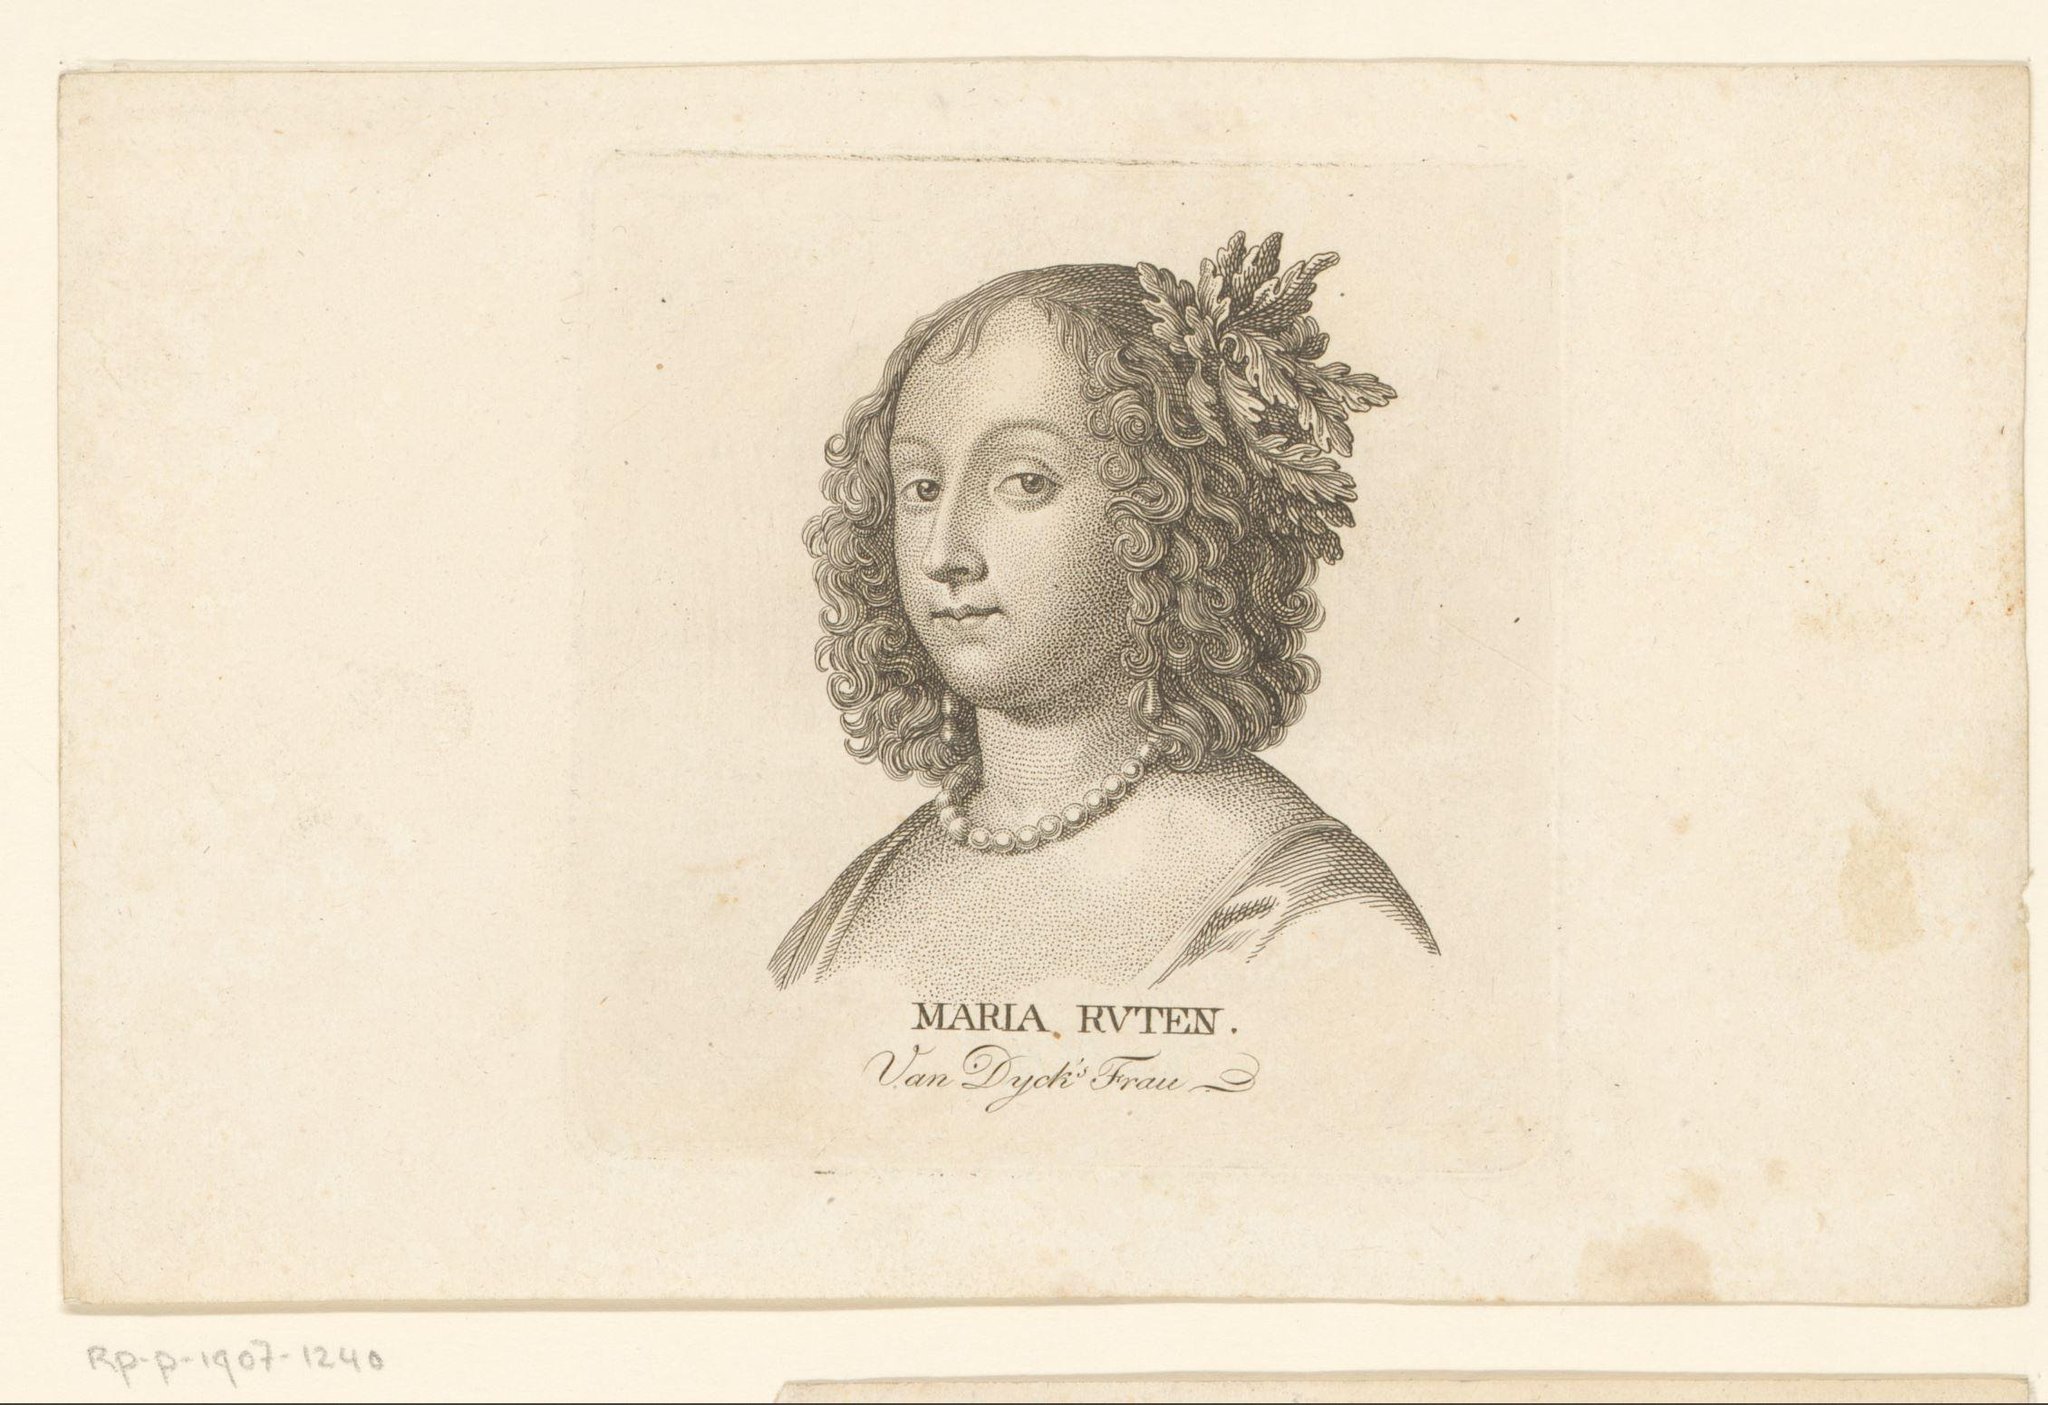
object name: print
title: Portret van Maria Ruten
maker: ernst ludwig riepenhausen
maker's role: print maker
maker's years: 1765-1840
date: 1775-1840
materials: paper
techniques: engraving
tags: historical persons - bb - woman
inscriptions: collector's mark: Lugt 2228